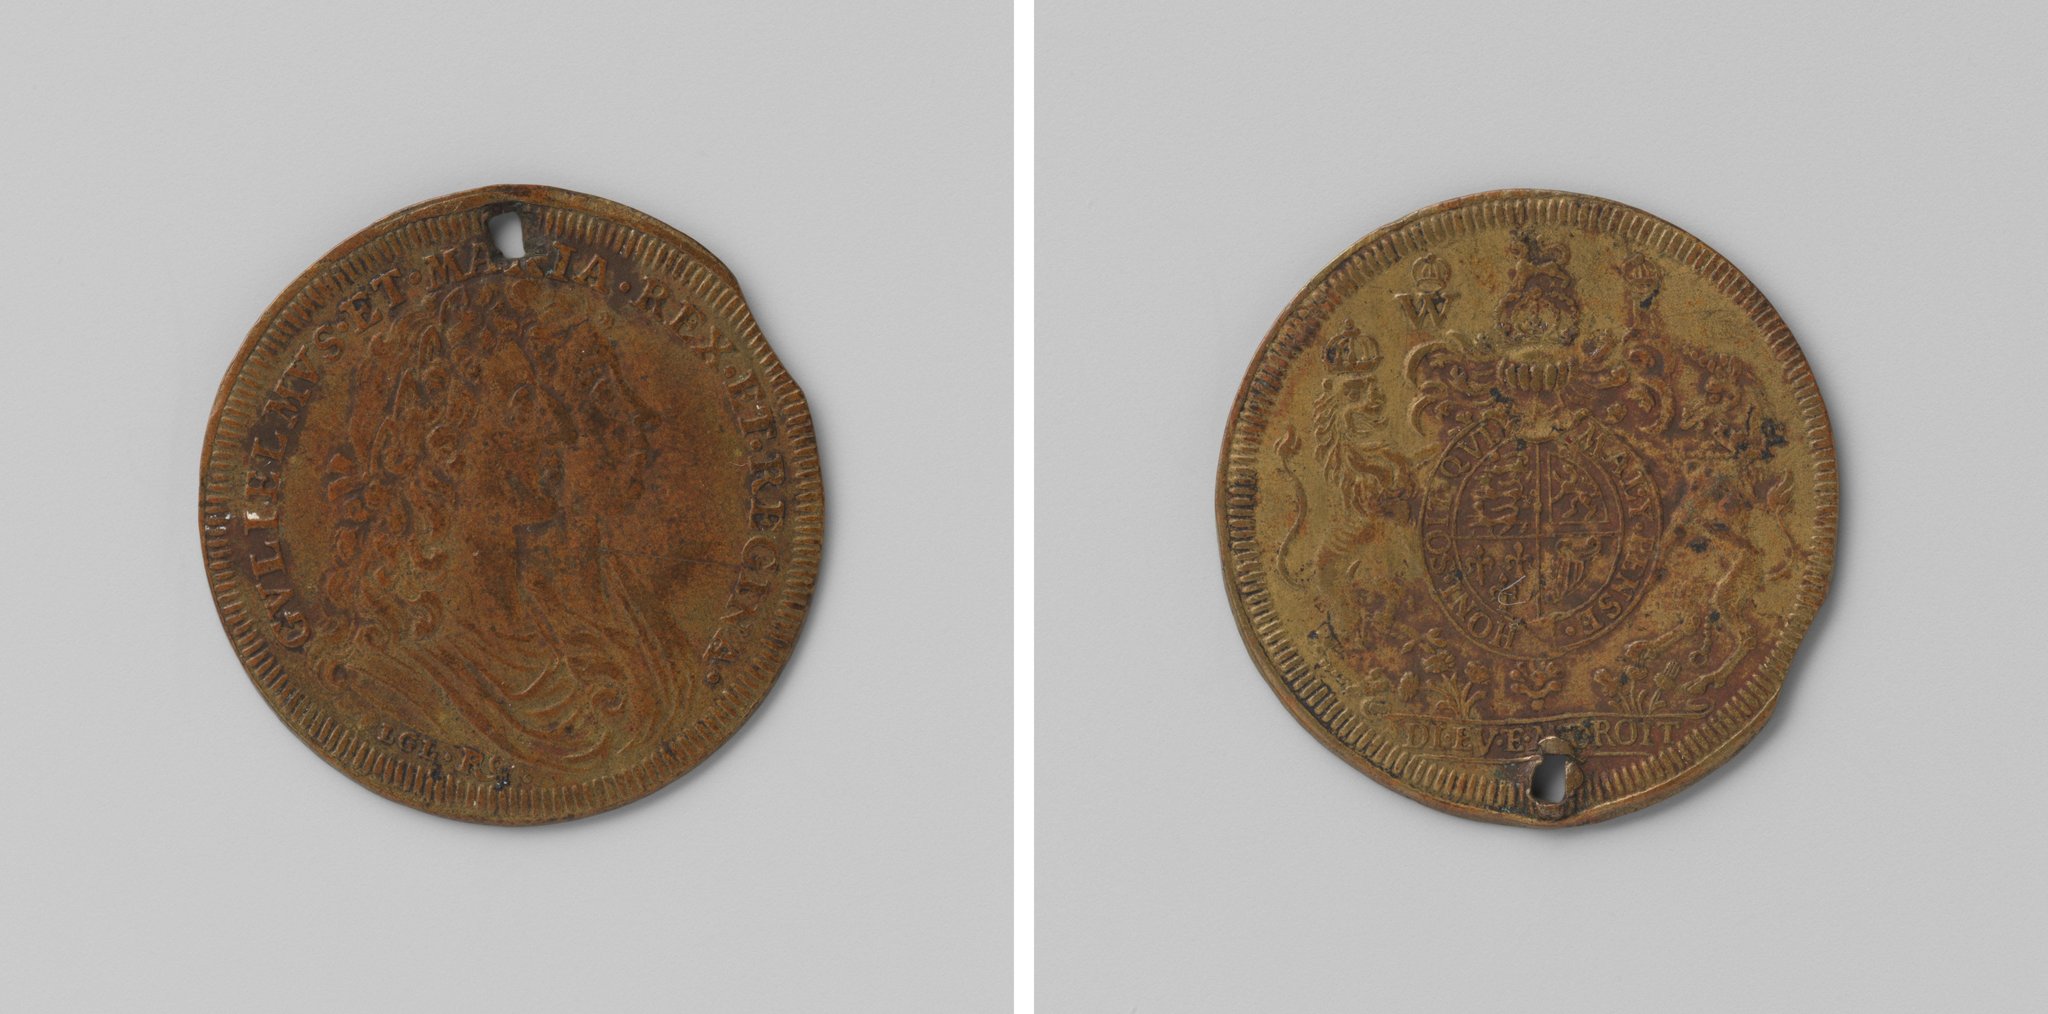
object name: jeton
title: Kroning van Willem III en Maria II Stuart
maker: lazarus gottlieb lauffer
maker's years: 1660-1700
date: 1689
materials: copper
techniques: striking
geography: nuremberg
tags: the hague, william iii (prince of orange and king of england, scotland, and ireland), maria ii stuart (koningin van engeland, schotland en ierland)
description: Koperen penning met gat. Voorzijde: borststuk man met lauwerkrans en vrouw binnen omschrift. Keerzijde: gekroond wapenschild omhangen met orde van kouseband en geflankeerd door gekroonde leeuw en eenhoorn onder letters W R en boven band met opschrift